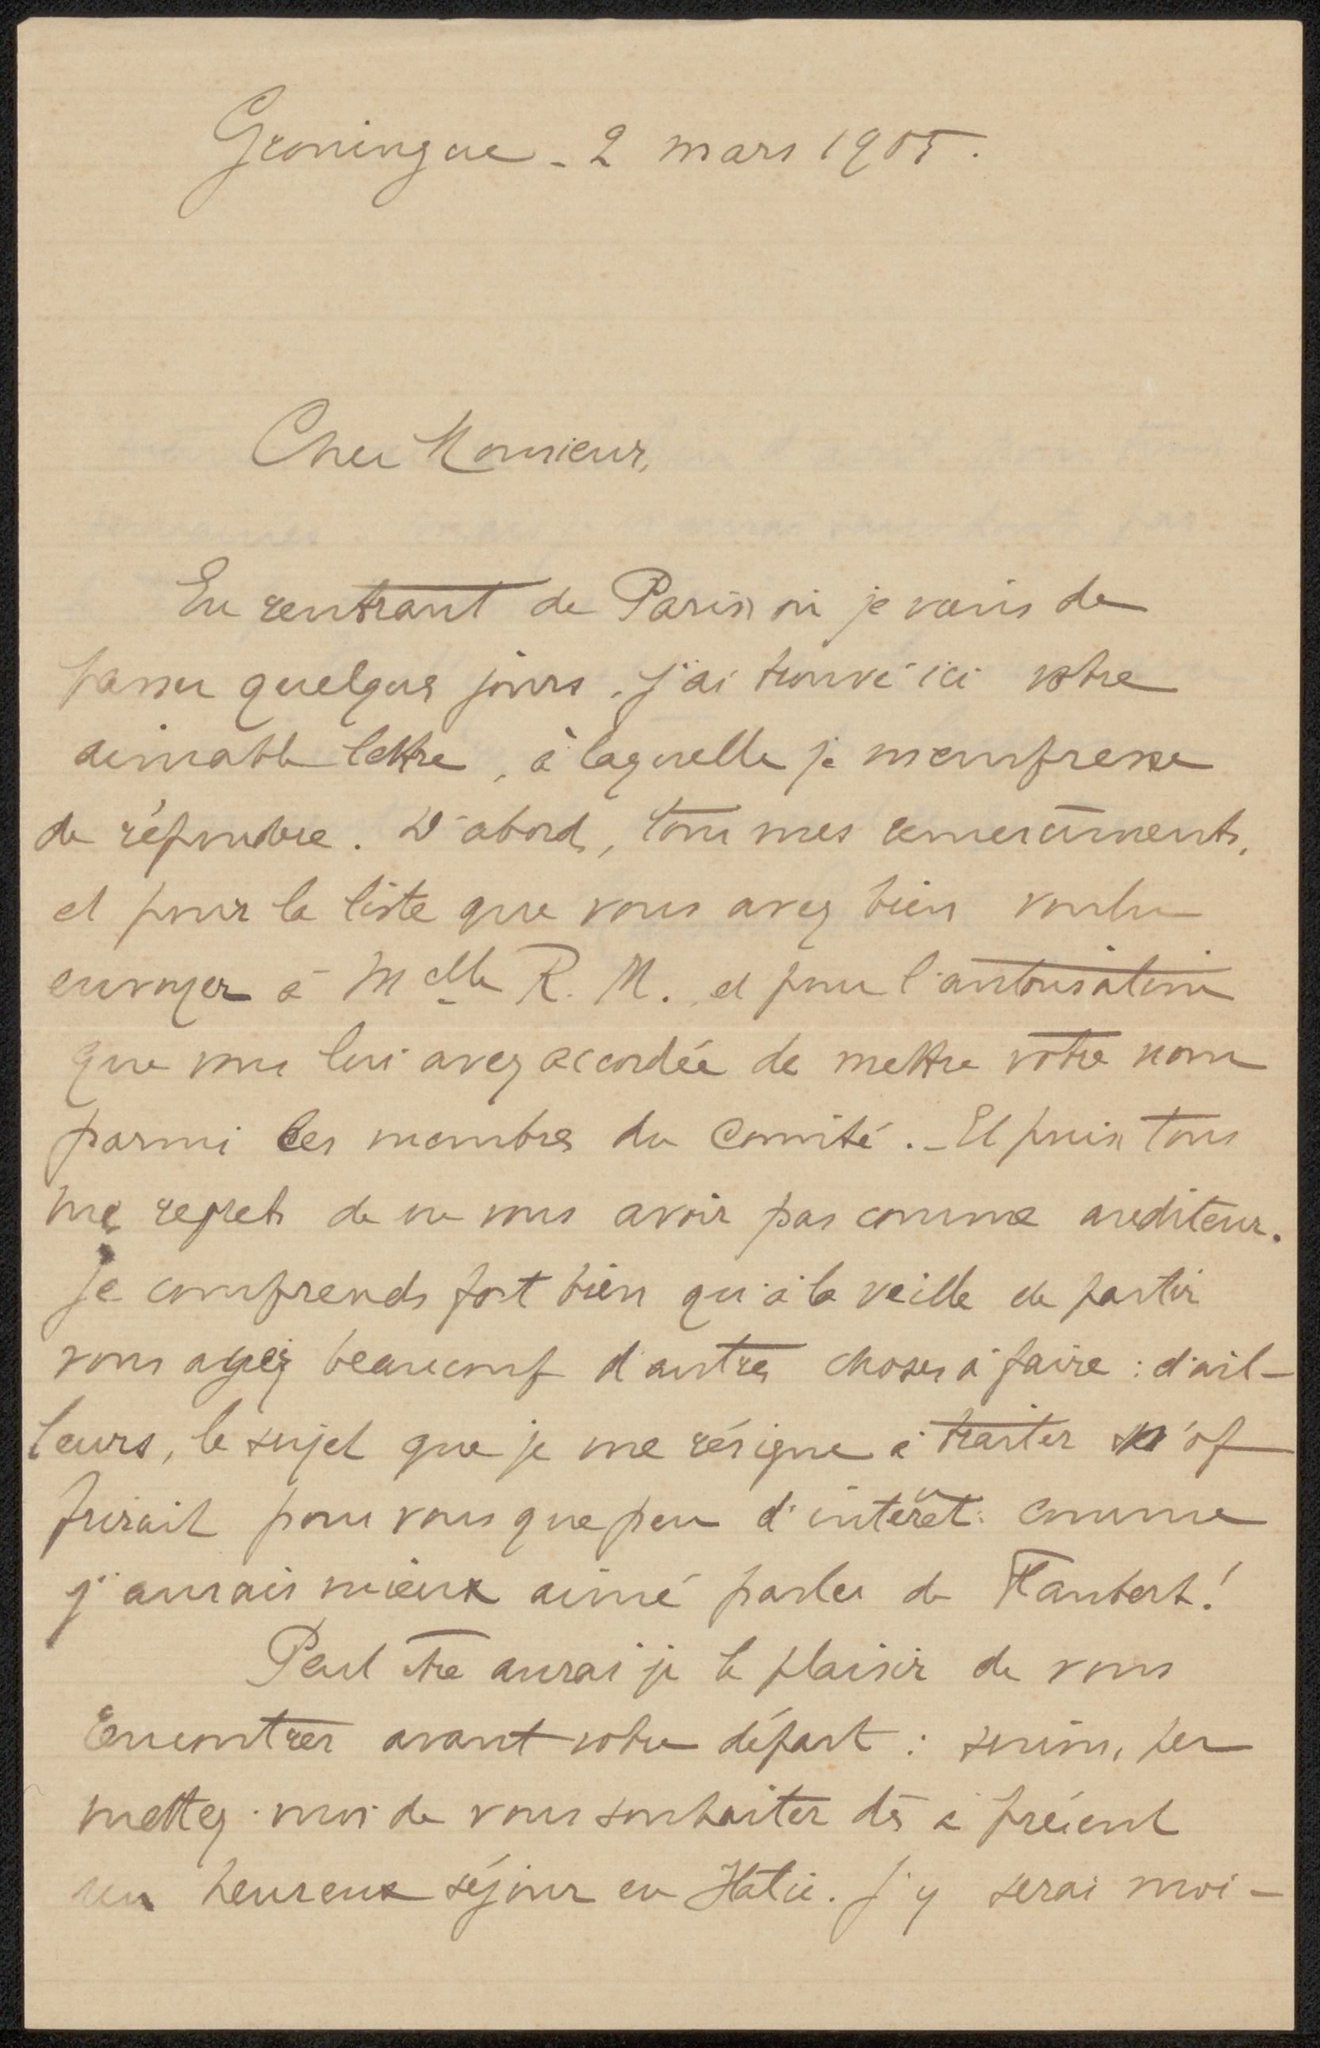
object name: letter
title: Brief aan Philip Zilcken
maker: maurice pernot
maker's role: journalist, letterkundige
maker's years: 1875-1948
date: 1905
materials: ink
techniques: pen, writing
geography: groningen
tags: gustave flaubert, the hague, draughtsman, philip zilcken, italy, paris, venice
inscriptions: collector's mark: ‘RPK’